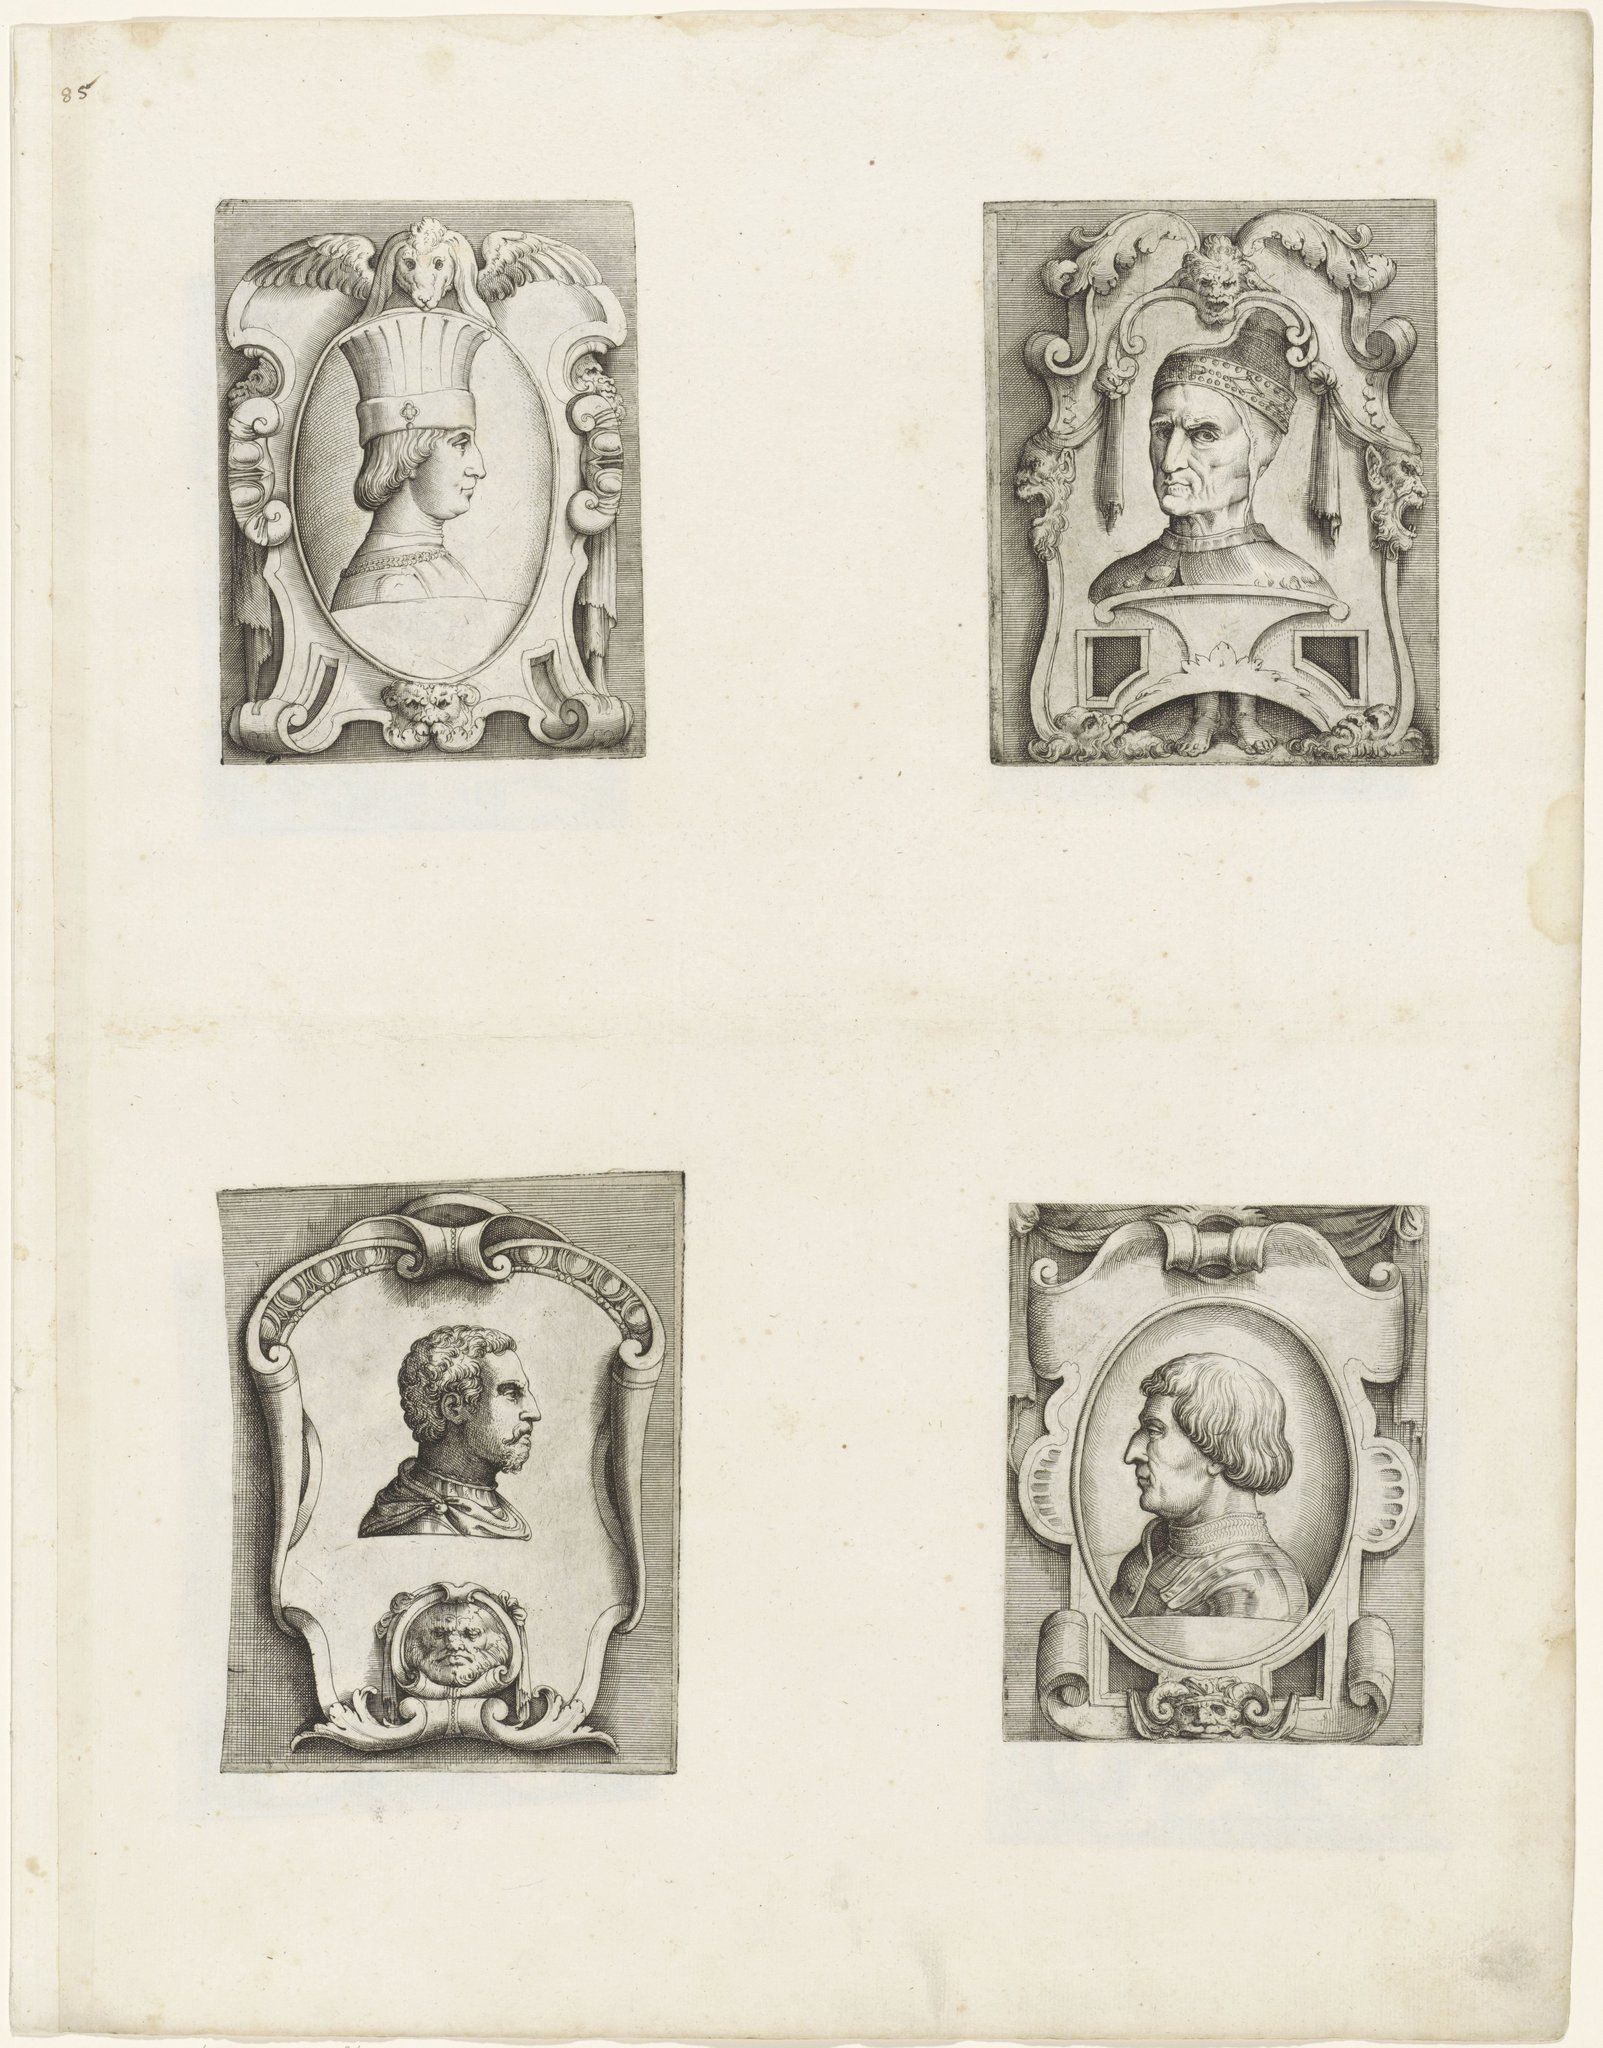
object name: album leaf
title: Portret van Borso d'Este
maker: battista franco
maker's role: draughtsman, painter, print maker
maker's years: 1510-1561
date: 1520-1561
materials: paper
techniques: engraving, etching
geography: italy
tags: naples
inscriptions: number: ‘85’, watermark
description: Folio 85 uit het prentalbum van Johann Georg I. Zobel von Giebelstadt (Röttingen 1543-07-20 - Bamberg 1580-09-07), de latere bisschop van Bamberg. Het album is vermoedelijk samengesteld tussen 1568 en 1570 in Venetië. Het album werd in 1999 uit elkaar genomen door een antiquair. De in totaal 124 folio's met prenten uit het "Zobel Album" werden aangekocht door verschillende musea en privéverzamelingen. De grootste groep (68 folio's) bevindt zich in de collectie van het Rijksmuseum. Naar portretmedaillons ontworpen door Antonio Pisanello. RP-P-OB-105.259 zit vast aan RP-P-OB-105.260.